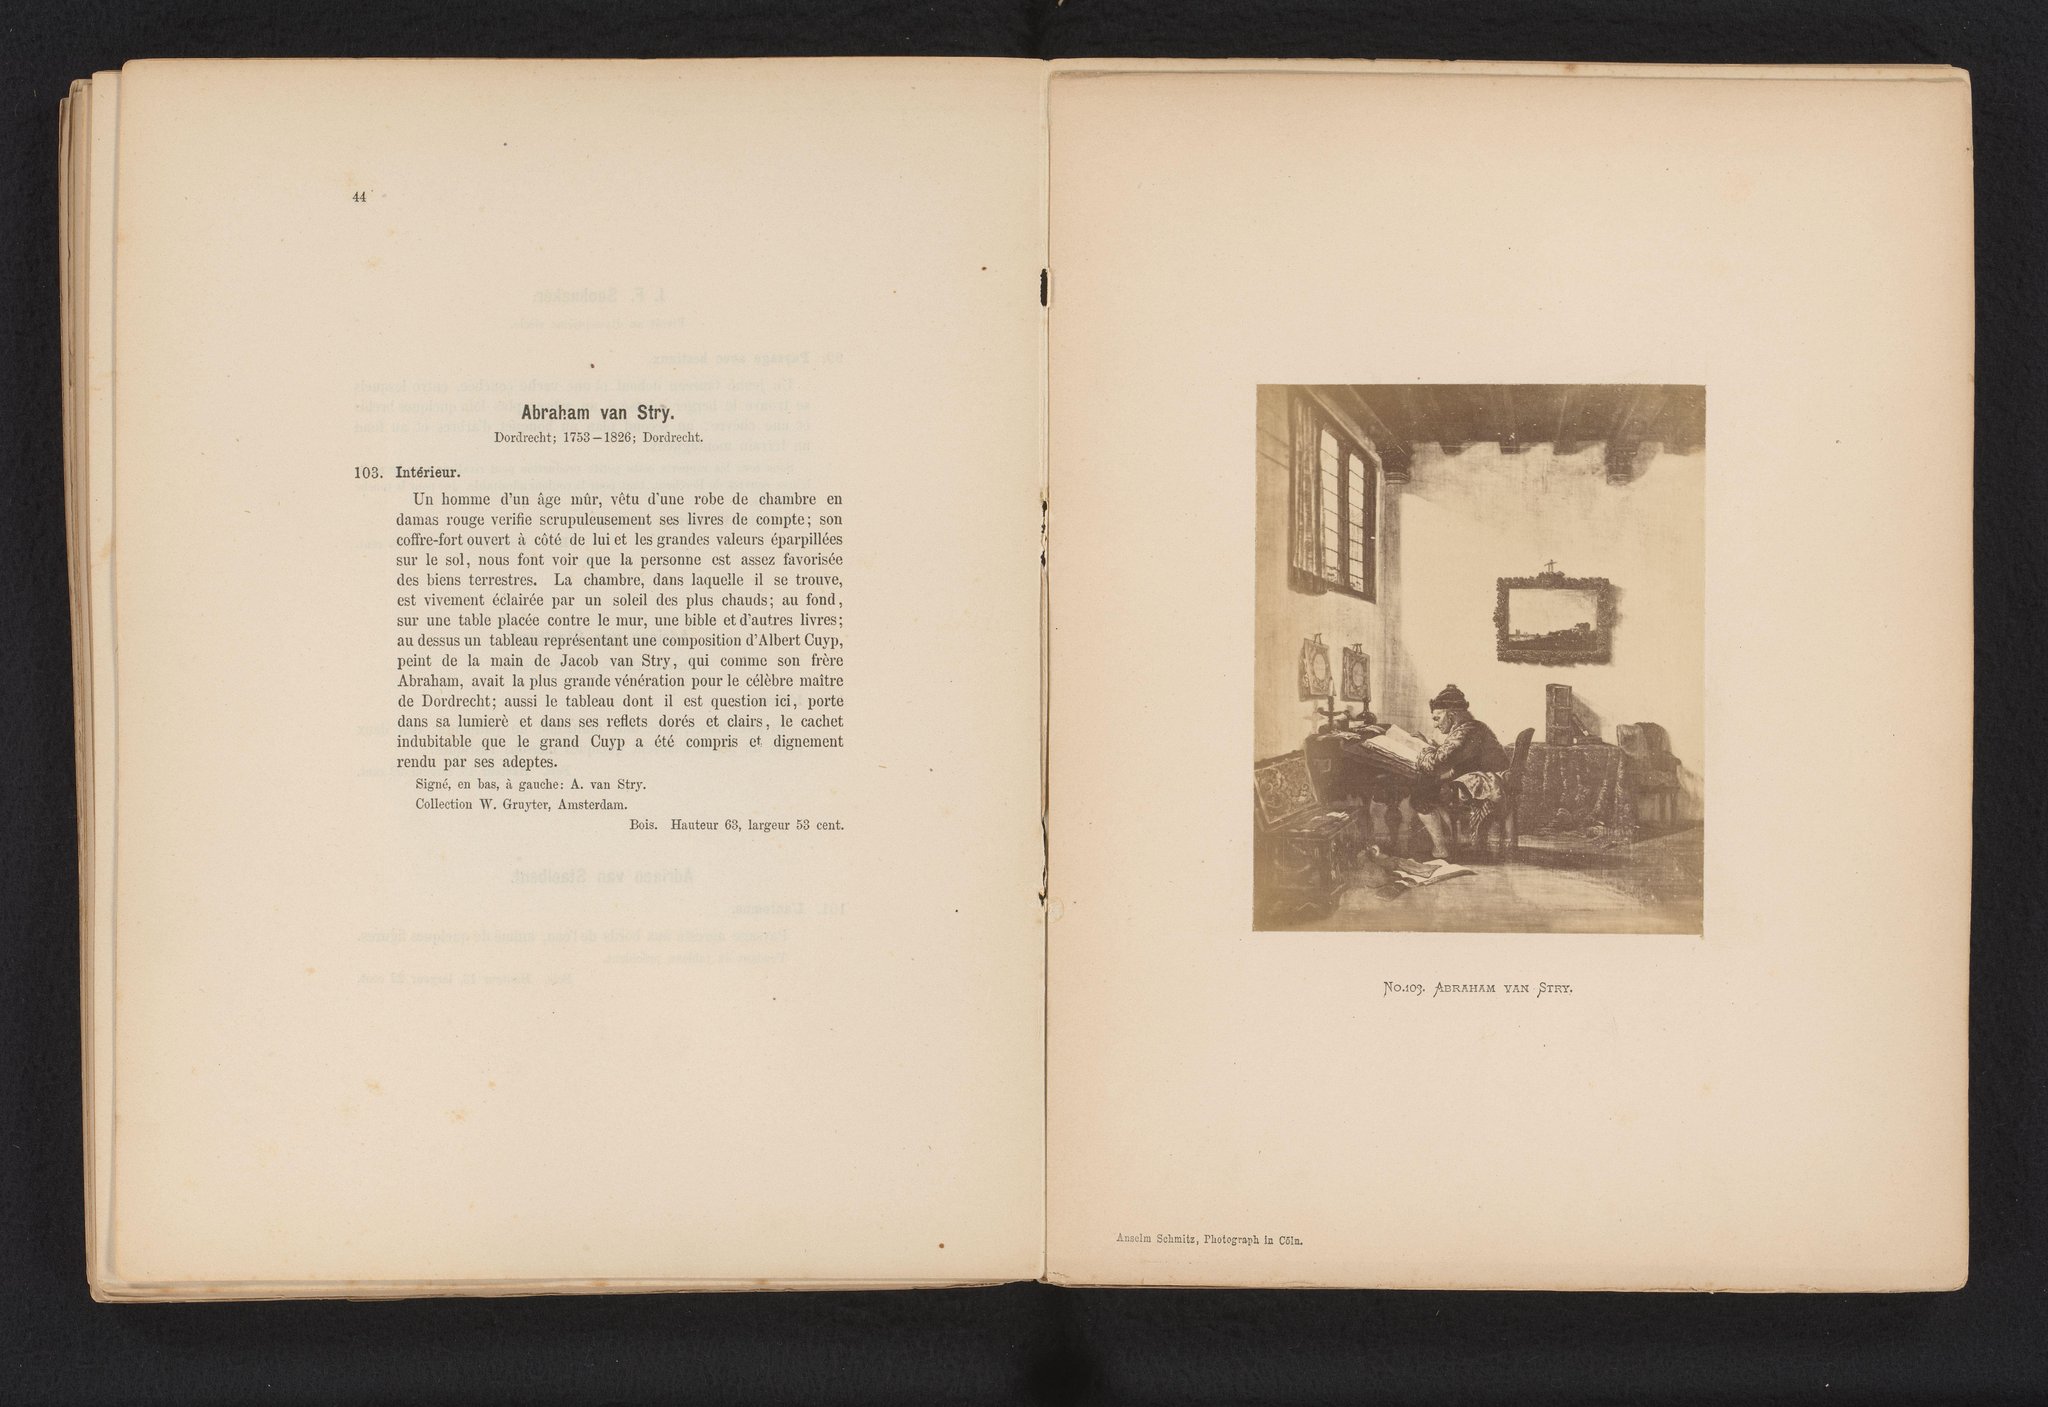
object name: photograph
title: Fotoreproductie van een schilderij van een lezende man door Abraham van Strij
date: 1871-1876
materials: photographic support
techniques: albumen print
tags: reading, study; 'studiolo'; library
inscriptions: inscription: ‘No. 103. Abraham van Stry’